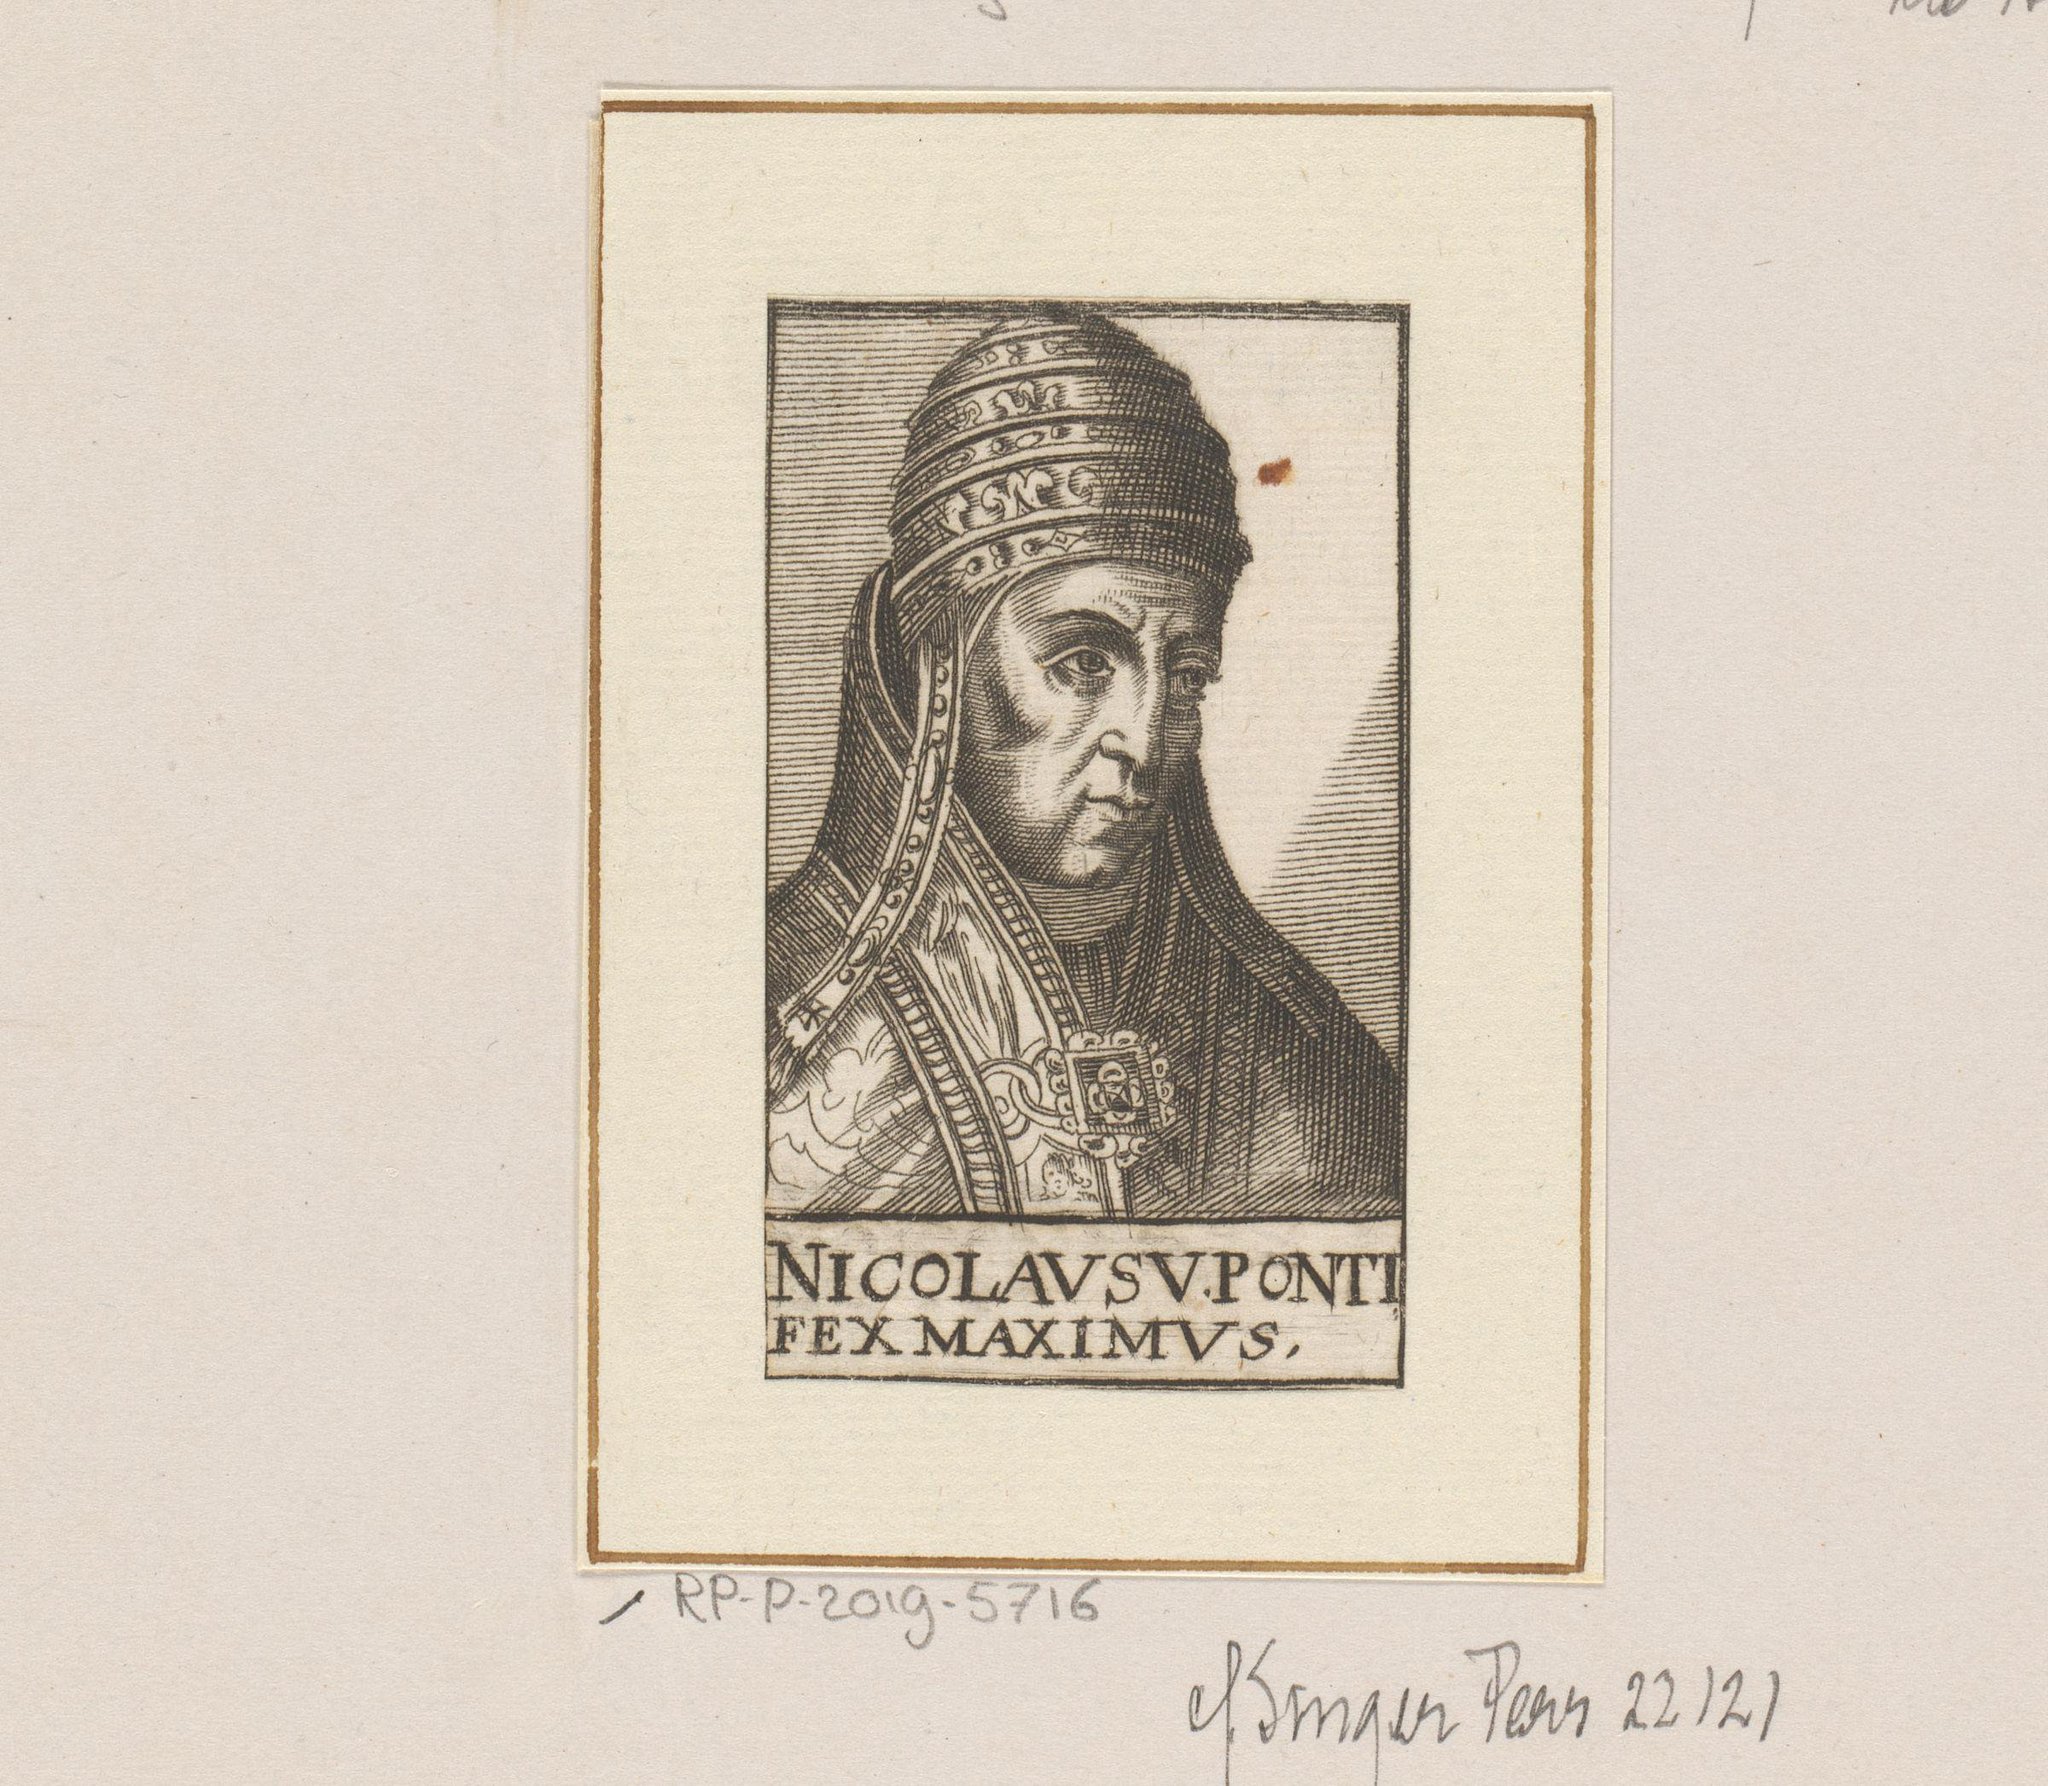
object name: book illustration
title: Nicolaus V. Pontifex Maximus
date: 1688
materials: paper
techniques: engraving, etching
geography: nuremberg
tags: historical persons, pope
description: Prent uit: Freher, Paul. Theatrum virorum eruditione clarorum. Neurenberg: Johann Hoffmann, 1688.